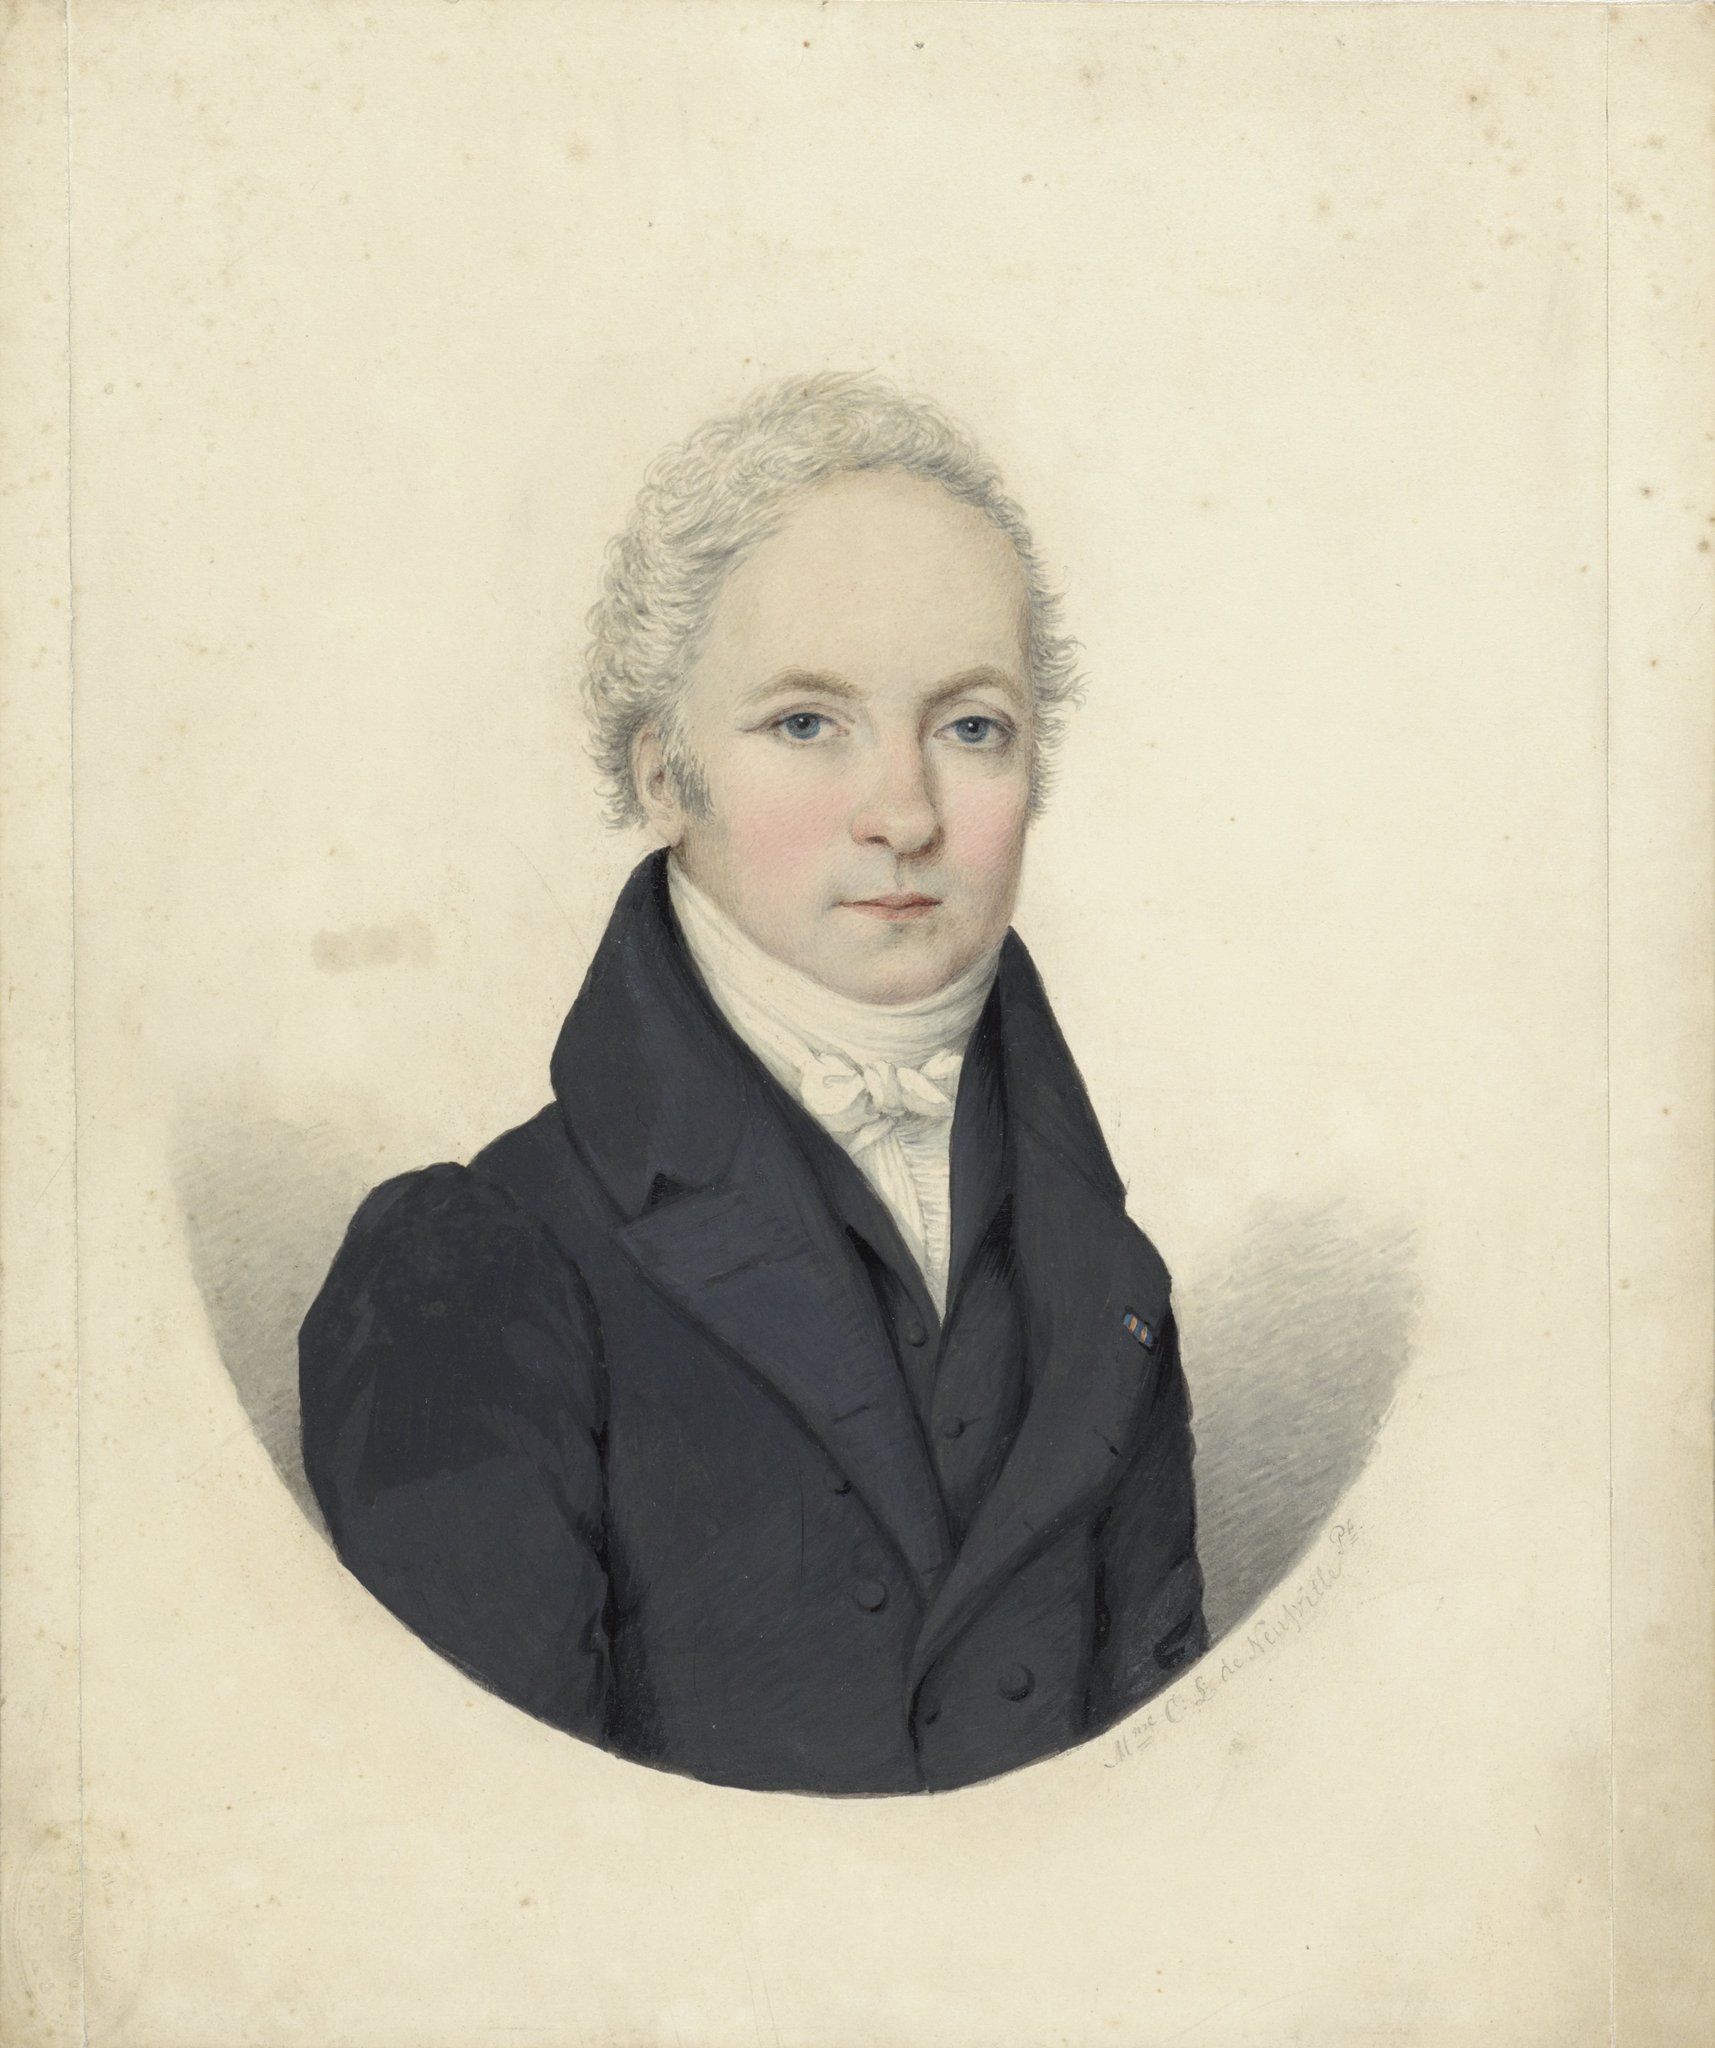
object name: drawing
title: Borstbeeld in ovaal, portret van Georg (?) Clifford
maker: louise charlotte de neufville-ritter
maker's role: draughtsman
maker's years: 1779-1859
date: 1789-1895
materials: paper, pencil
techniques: brush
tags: historical persons